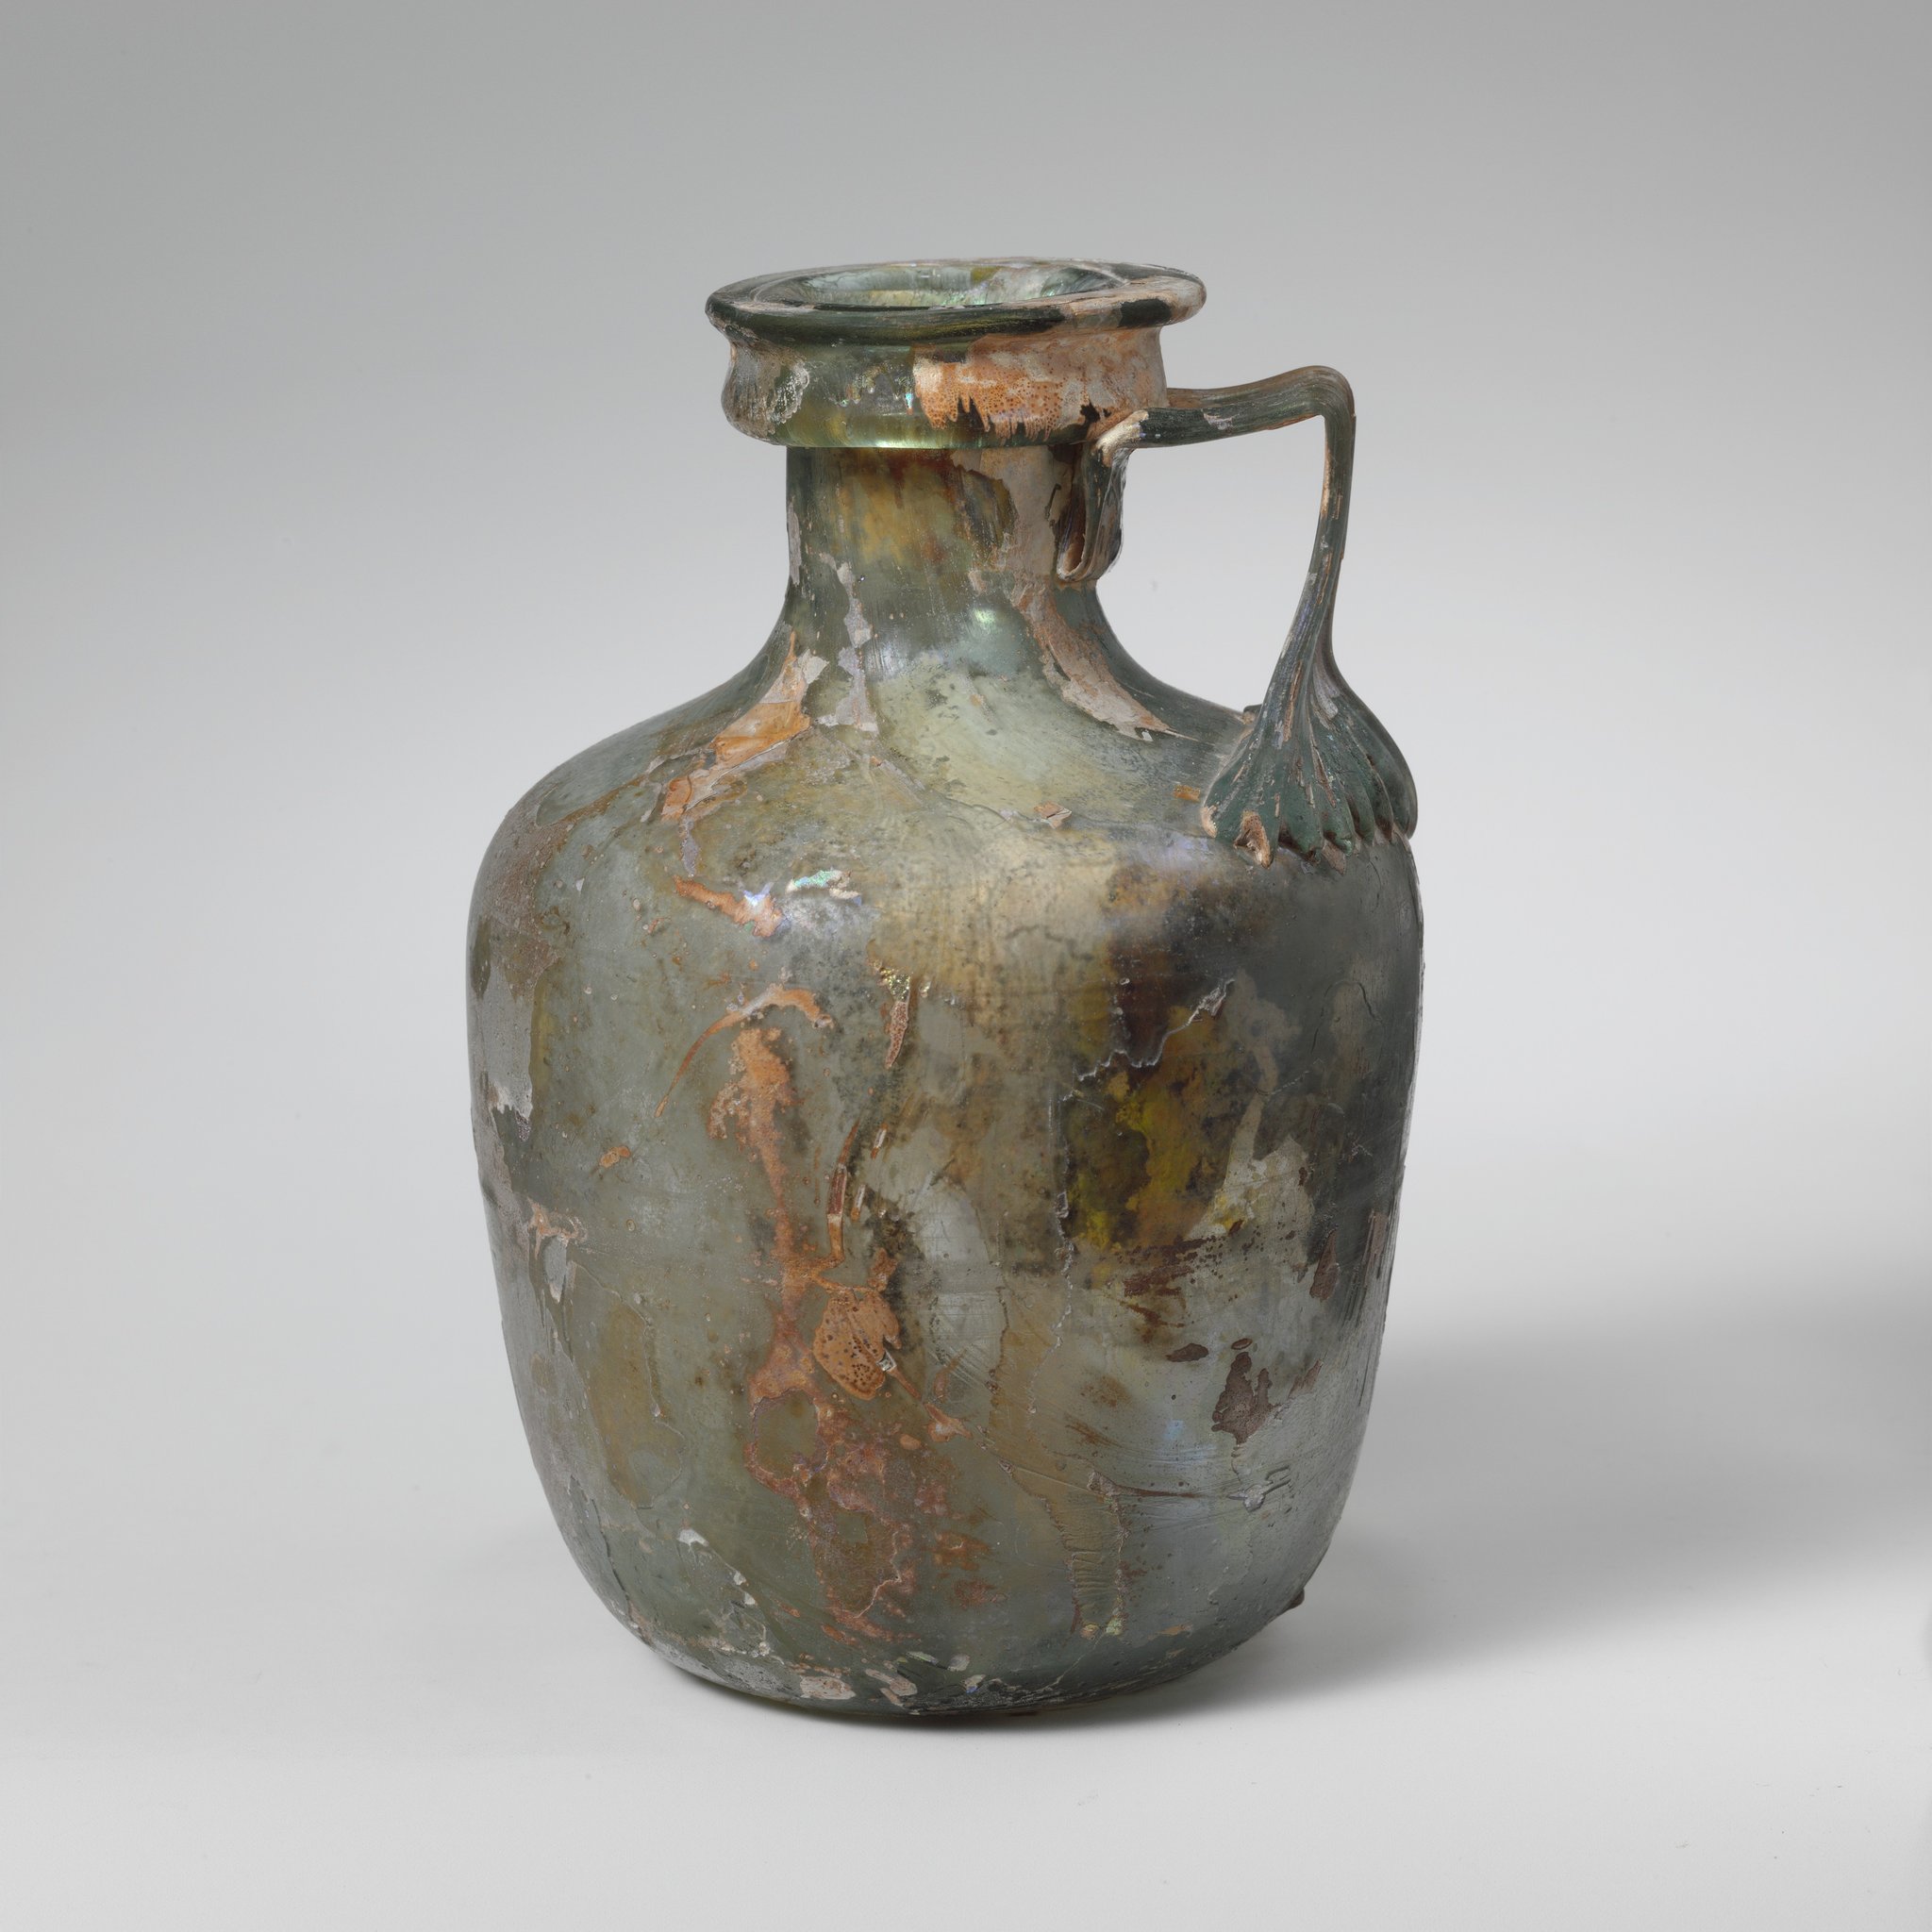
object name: jug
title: Glass jug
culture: roman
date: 34-200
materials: glass